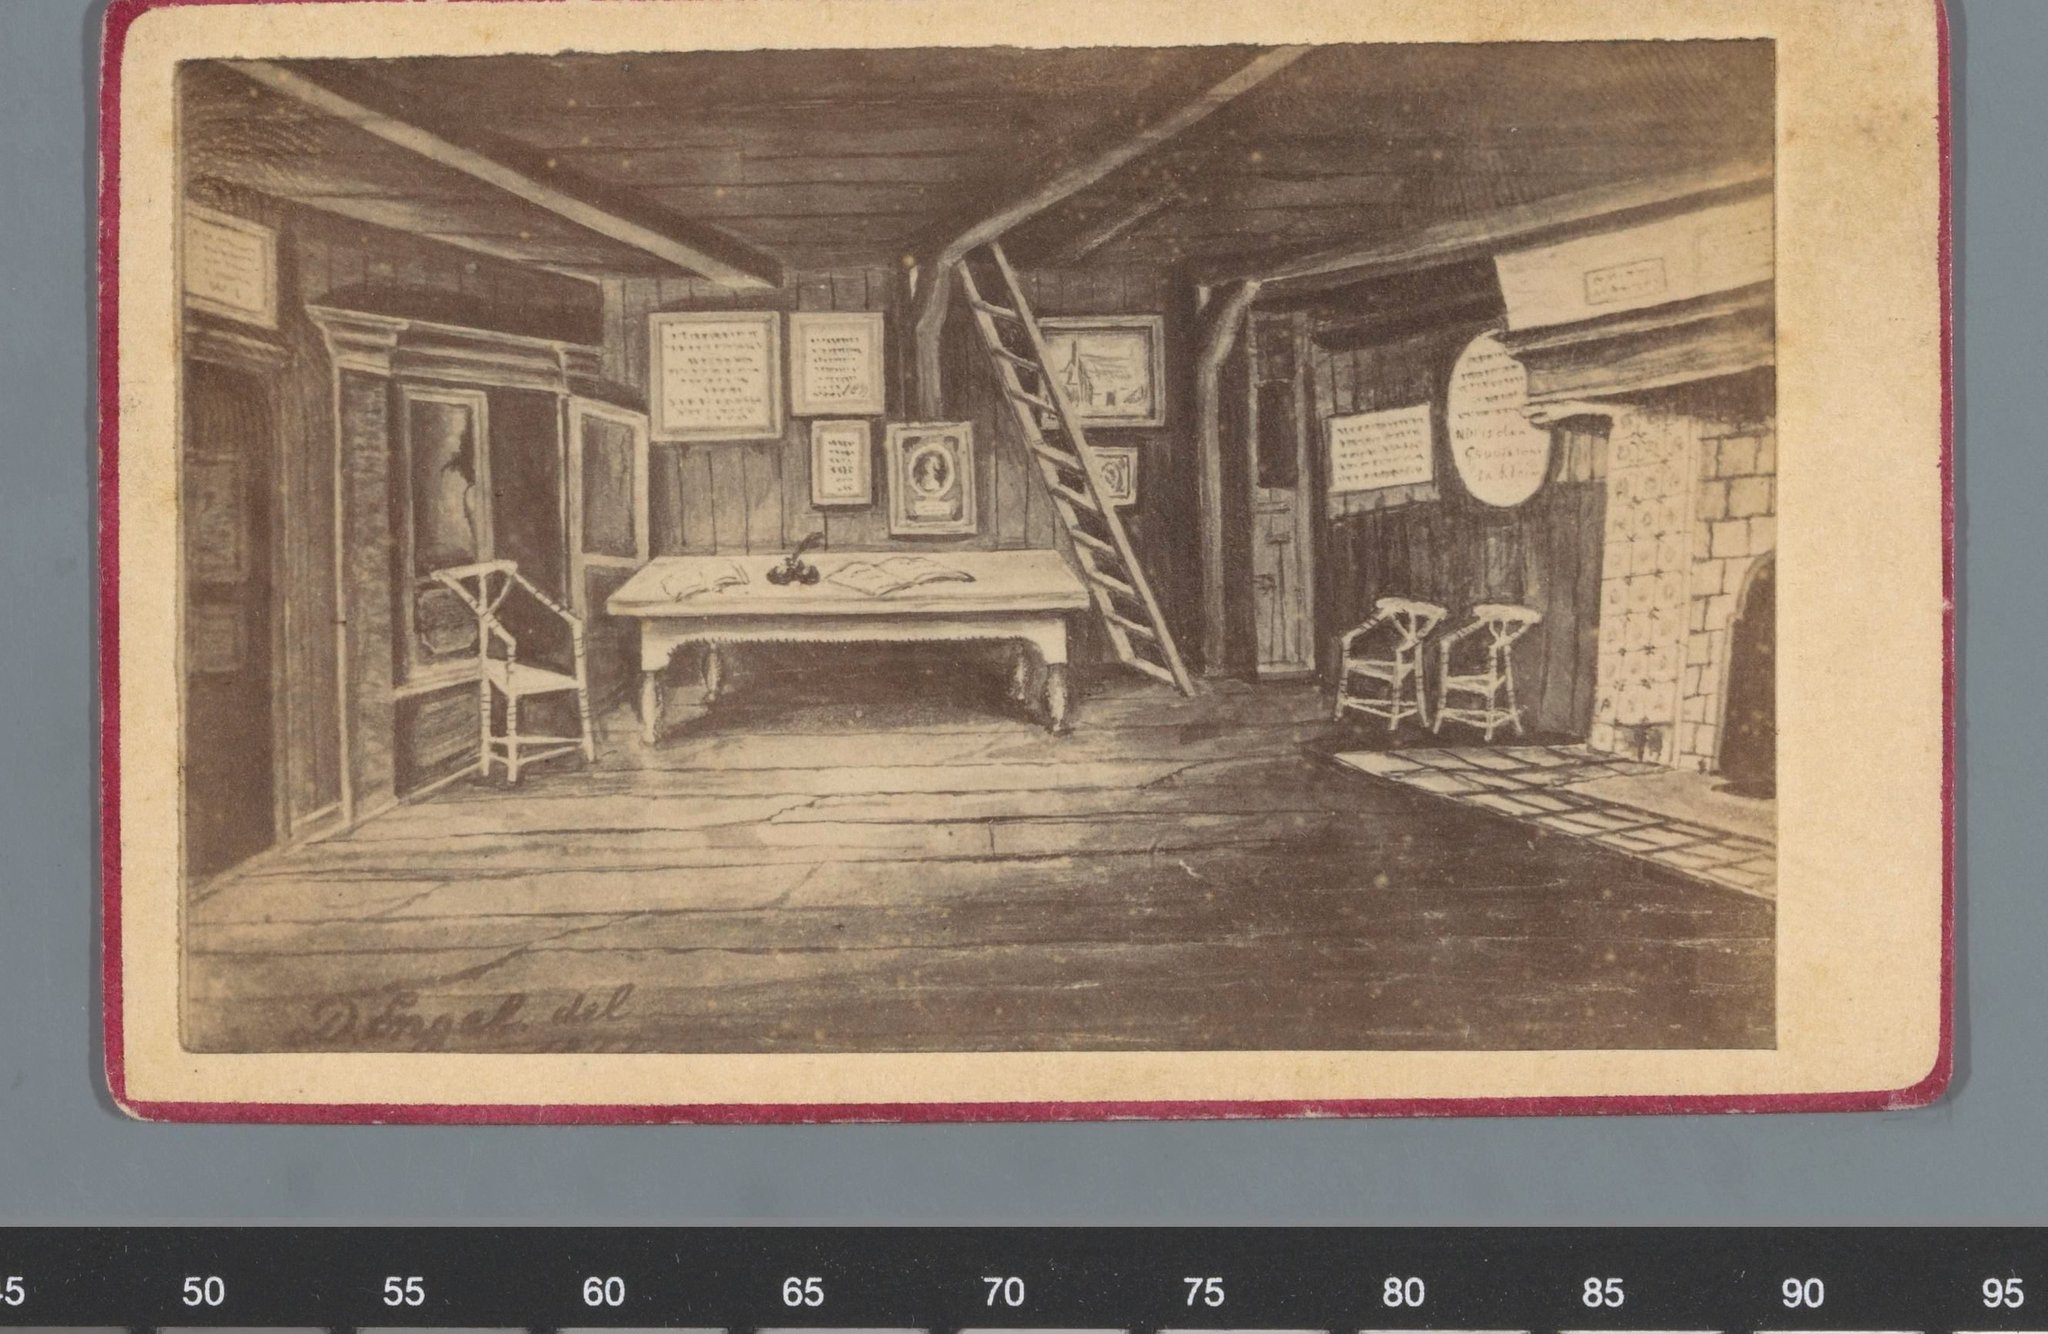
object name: reproduction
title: Fotoreproductie van een tekening, voorstellende een interieur van het Tsaar Peterhuisje te Zaandam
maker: dirk engel (fotograaf)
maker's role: fotograaf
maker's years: 1829-1888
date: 1808-1874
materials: cardboard, photographic support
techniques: albumen print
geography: zaandam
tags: housing, interior ~ representation of a building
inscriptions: inscription: ‘Czaar Peterhuisje Zaandam Aug 1874.’, name: ‘Photographie van D. Engel Zaandam’